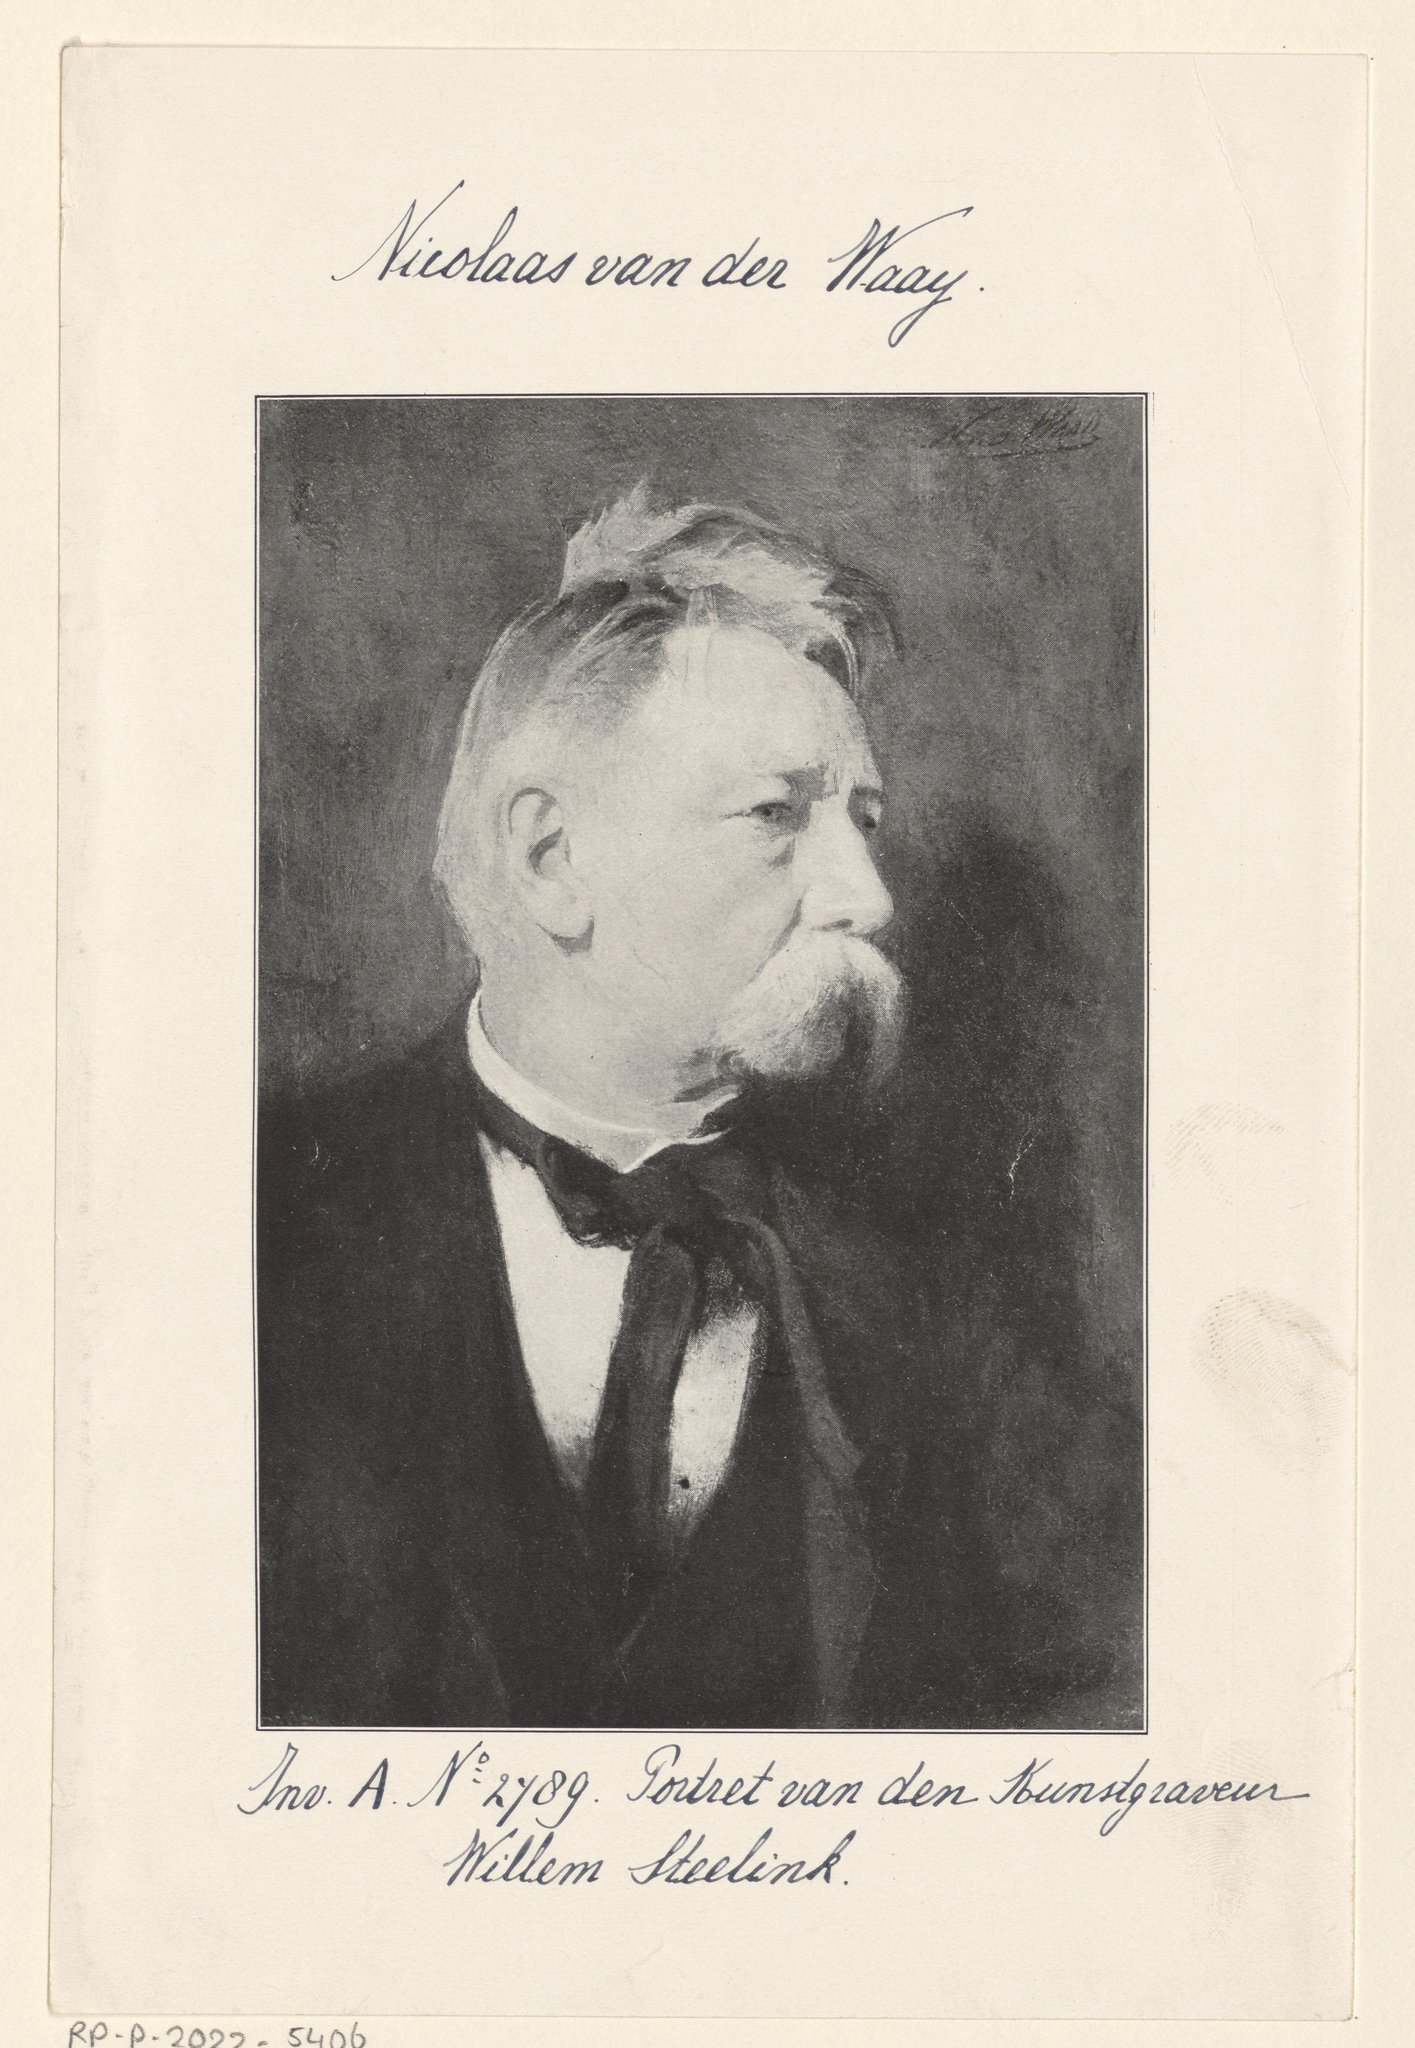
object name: photomechanical print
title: Portret van Willem Steelink Sr.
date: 1900-1970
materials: paper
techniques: autotype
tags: amsterdam, print maker, draughtsman, willem steelink (i), historical persons, portrait, self-portrait of artist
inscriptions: inscription: ‘Nicolaas van der Waay. / Inv. A. No 2789. Portret van den Kunstgraveur / Willem Steelink.’, collector's mark: 2228